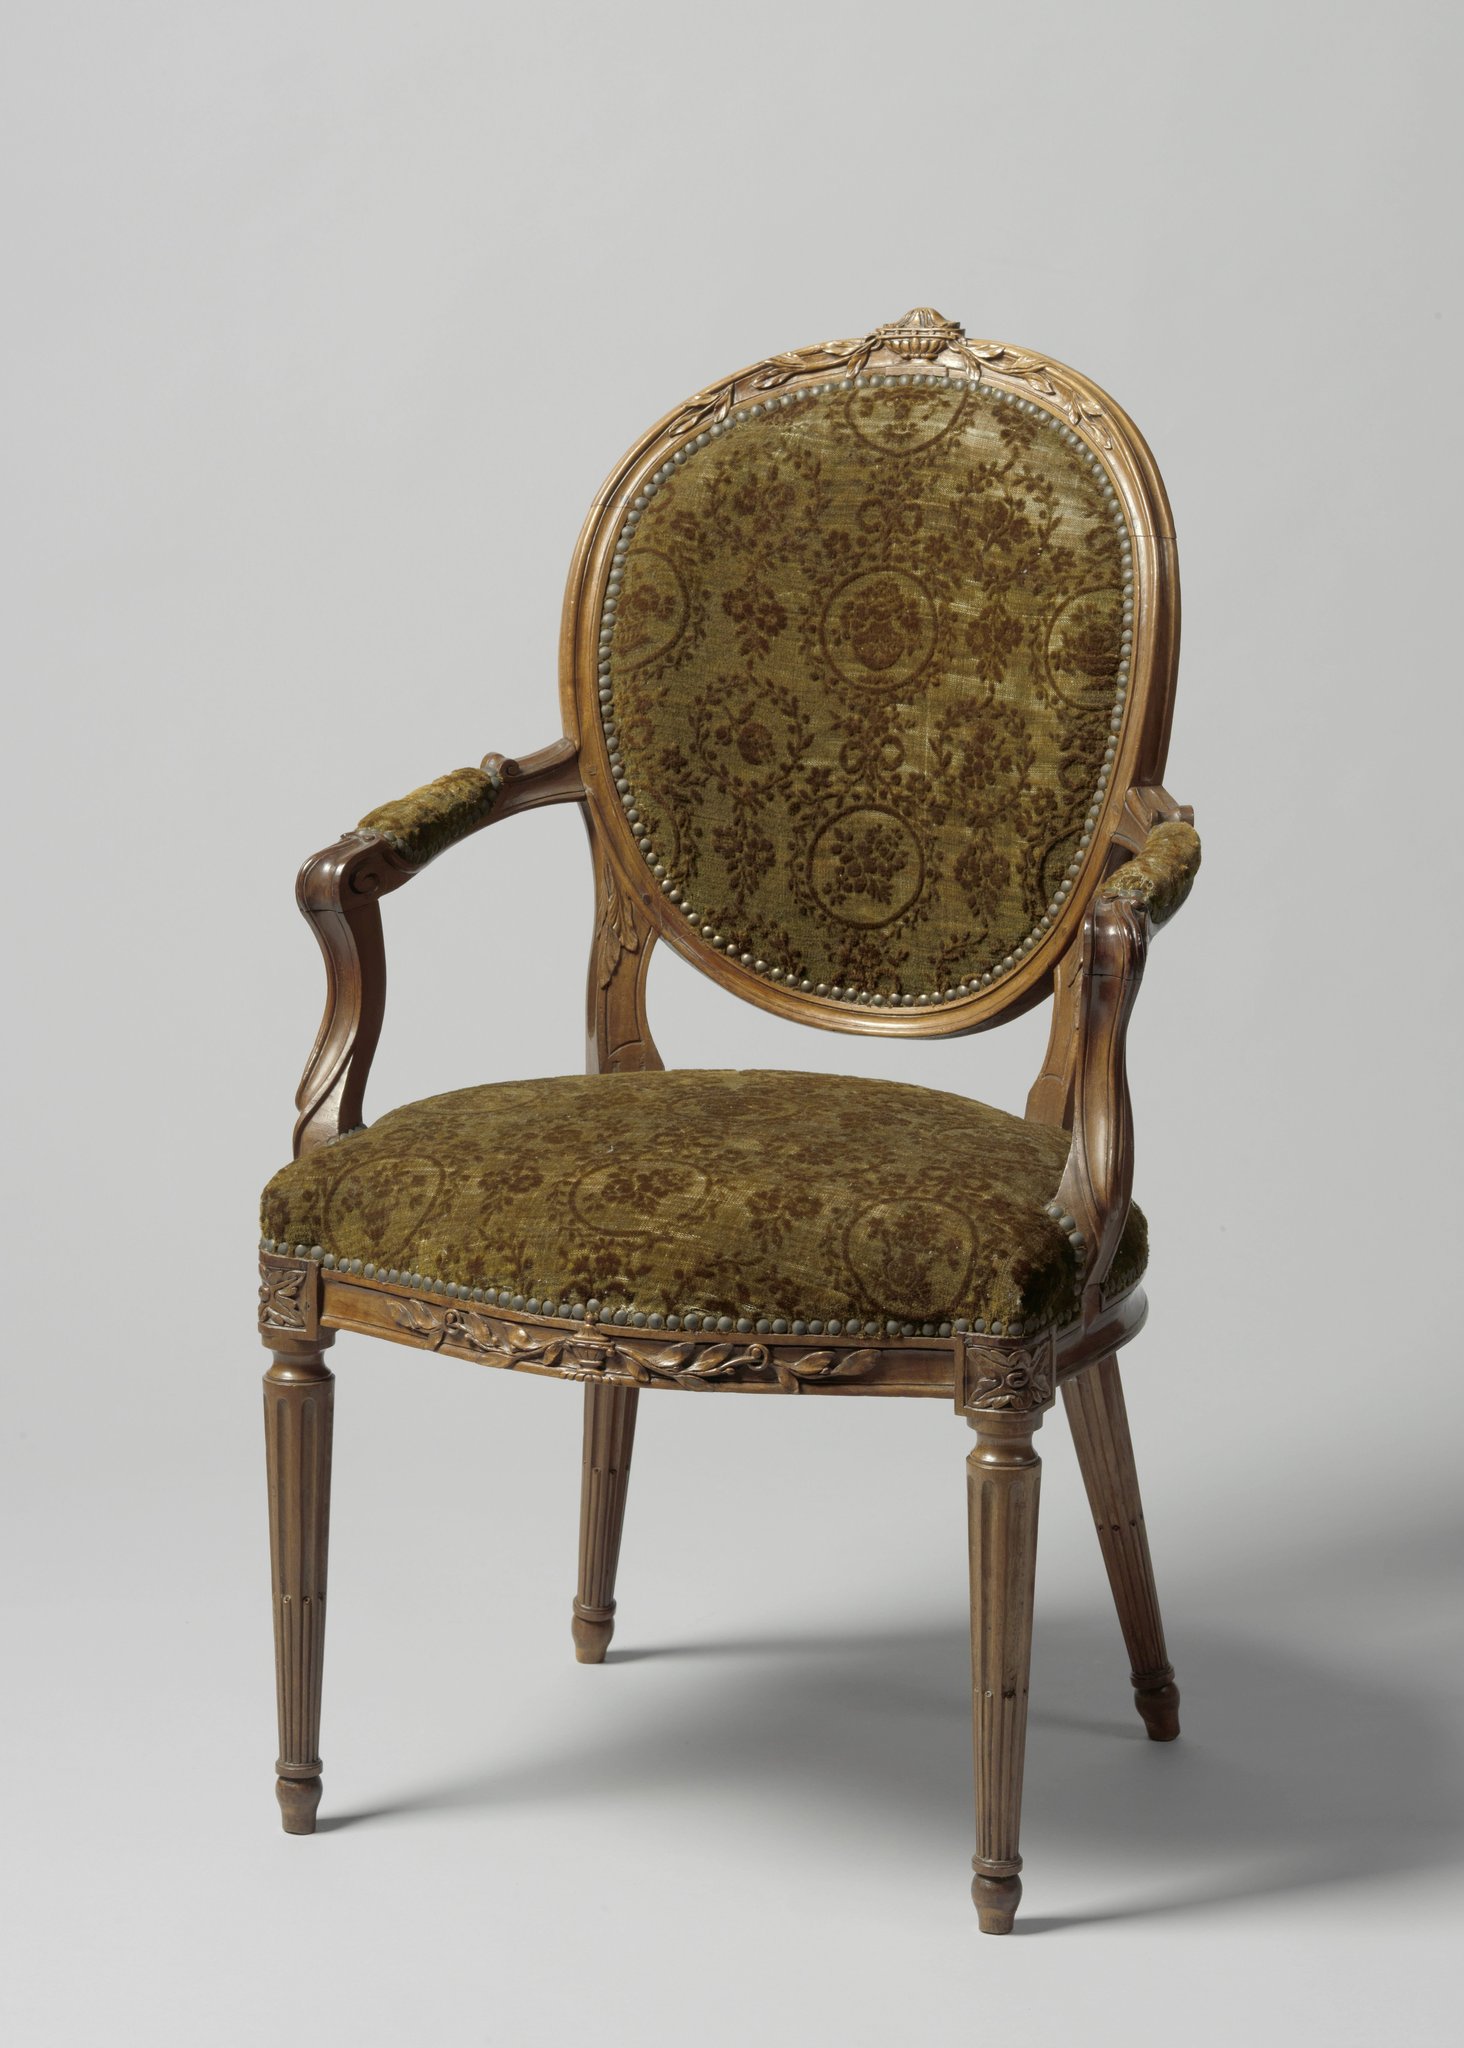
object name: chair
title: Stoel van mahoniehout, bekleed met groene trijp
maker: Anonymous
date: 1775-1800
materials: wood, textile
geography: northern netherlands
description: Stoel van mahoniehout, bekleed met groen trijp, behorend tot een ameublement. Van de conische, gecanneleerde poten wijken de achterpoten achterwaarts. Het zitraam is rond; het ovale geholde rugraam rust op C-vormige stutten met acanthusblad. De voorregel en de bovendorpel zijn versierd met een vaas, temidden van takken met bladeren, gehangen aan ringen. Zie tevens: BK-18323-a/m.